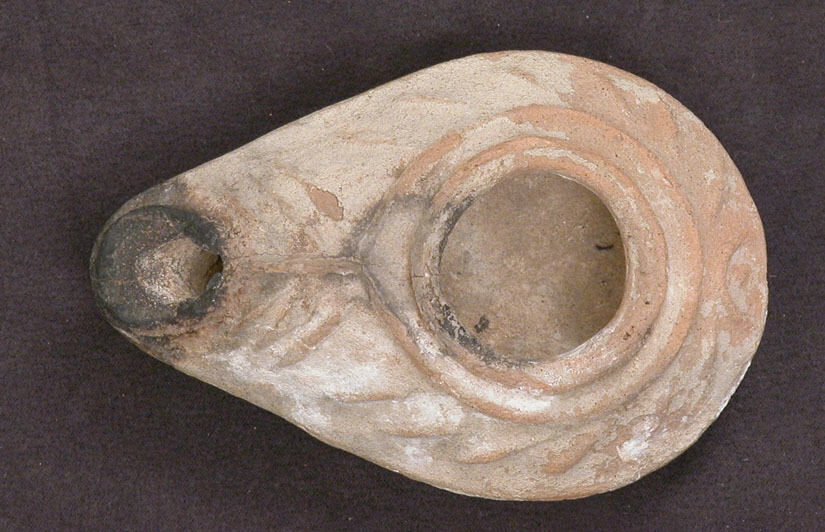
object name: lamp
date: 401-700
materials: earthenware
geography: palestine